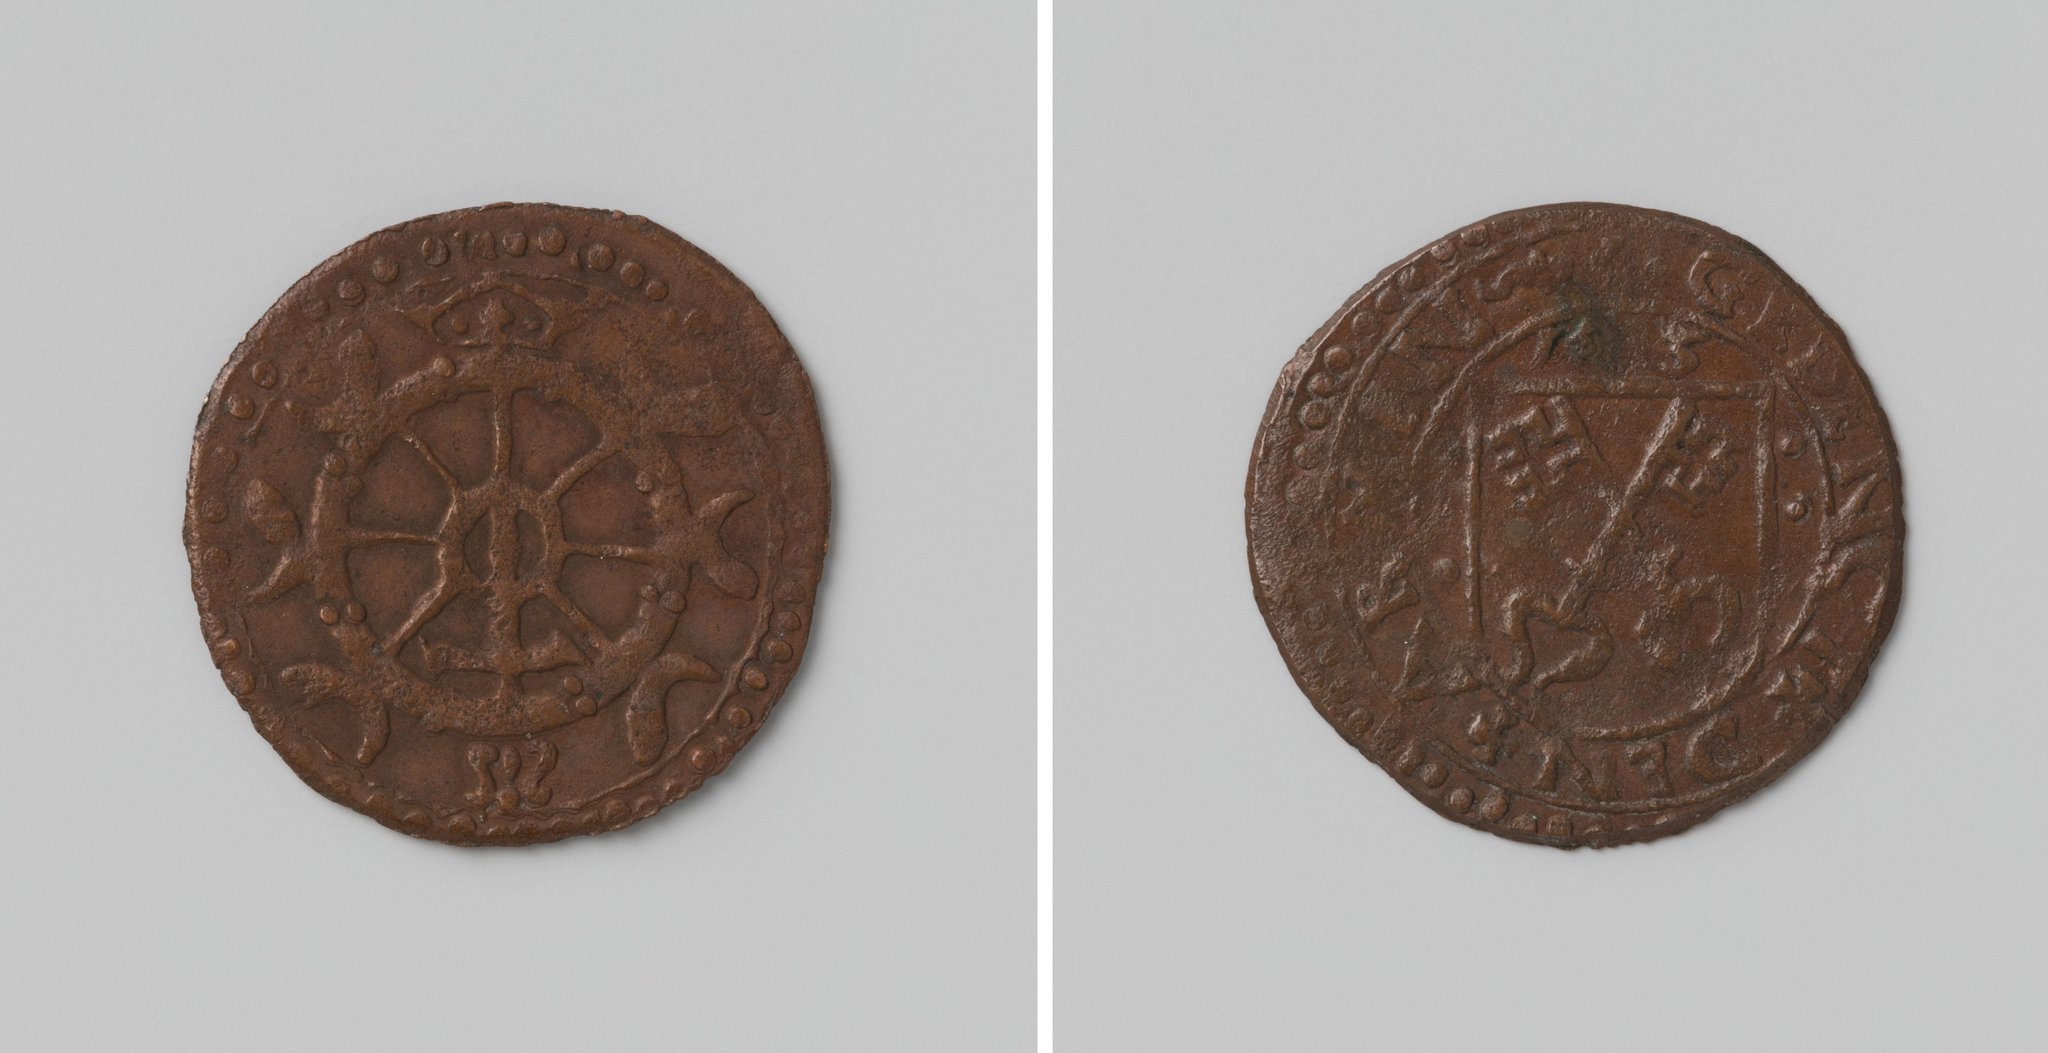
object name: alms token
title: Catharina-gasthuis van Leiden, armenpenning ter waarde van een oord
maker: Anonymous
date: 1573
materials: copper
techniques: striking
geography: leiden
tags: leiden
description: Koperen penning. Voorzijde: gekroond rad. Keerzijde: wapenschild onder jaartal binnen omschrift.